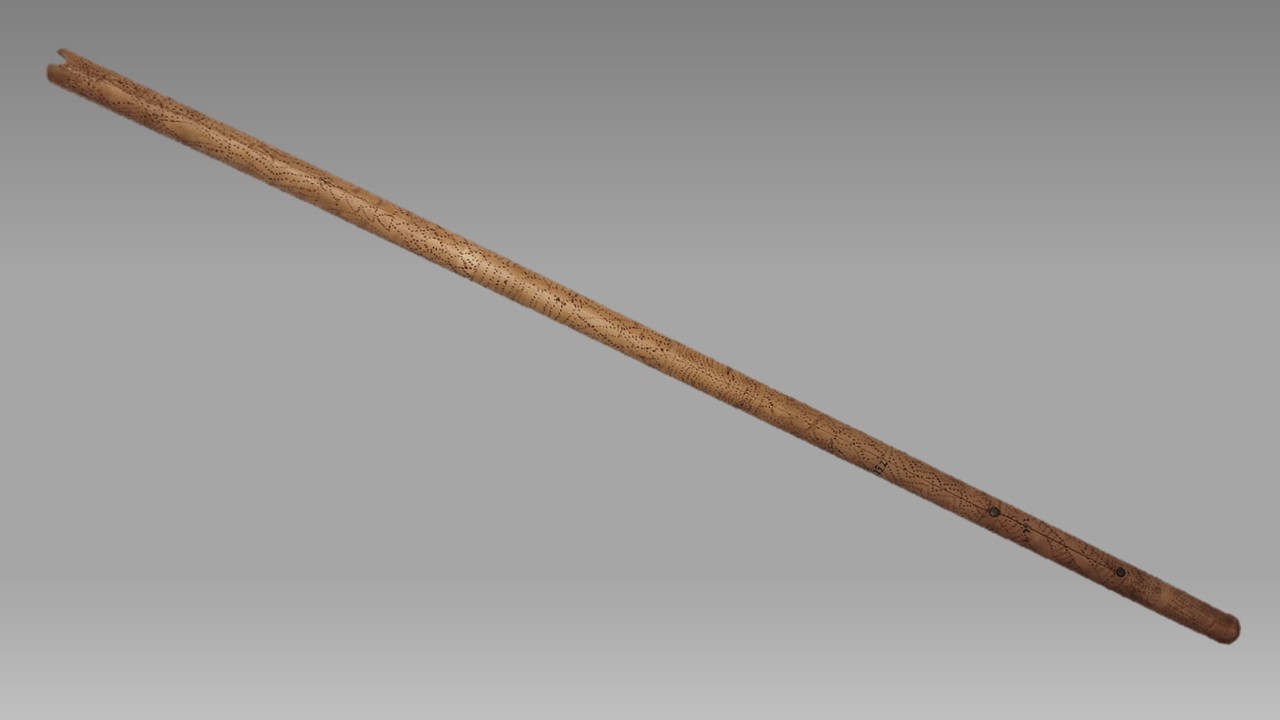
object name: gore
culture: melanesian, aoba island or vanuatuan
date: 1867-1900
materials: bamboo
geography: vanuatu